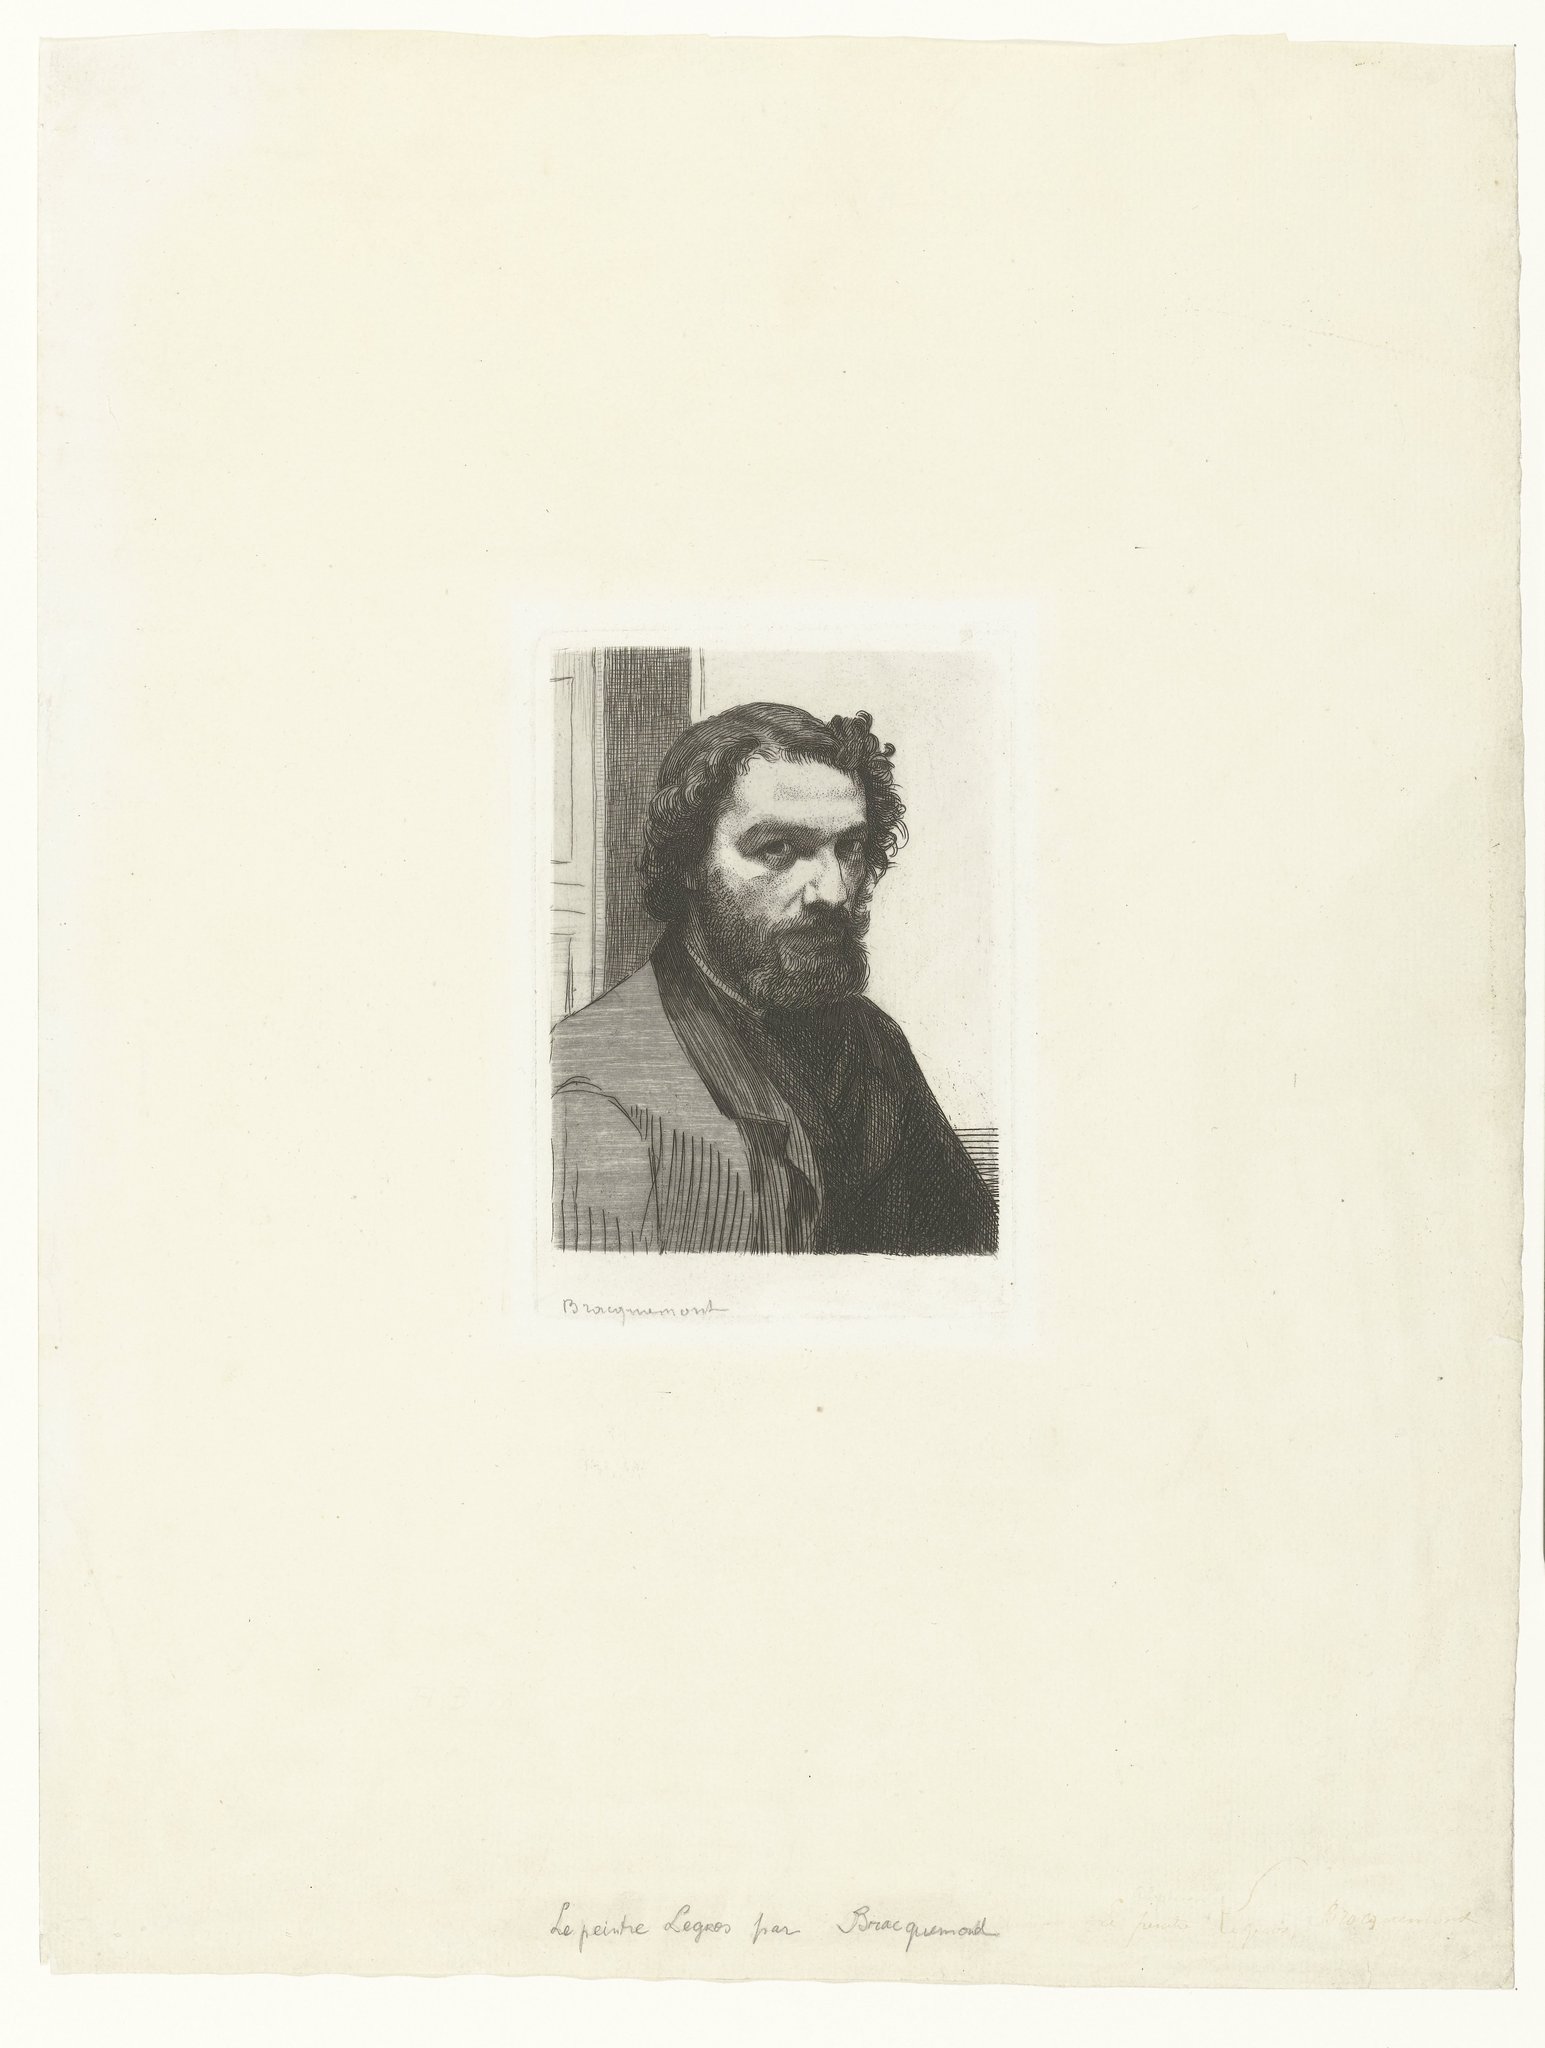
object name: print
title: Portret van kunstenaar Alphonse Legros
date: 1861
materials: paper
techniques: etching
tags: print maker, alphonse legros, portrait, self-portrait of artist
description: Gepubliceerd door Société des Aqua-Fortistes, Alfred Cadart (uitgever), Auguste Delatre (drukker), 1875. Bijna alle prenten uitgegeven door Cadart werden gedrukt door Delatre.